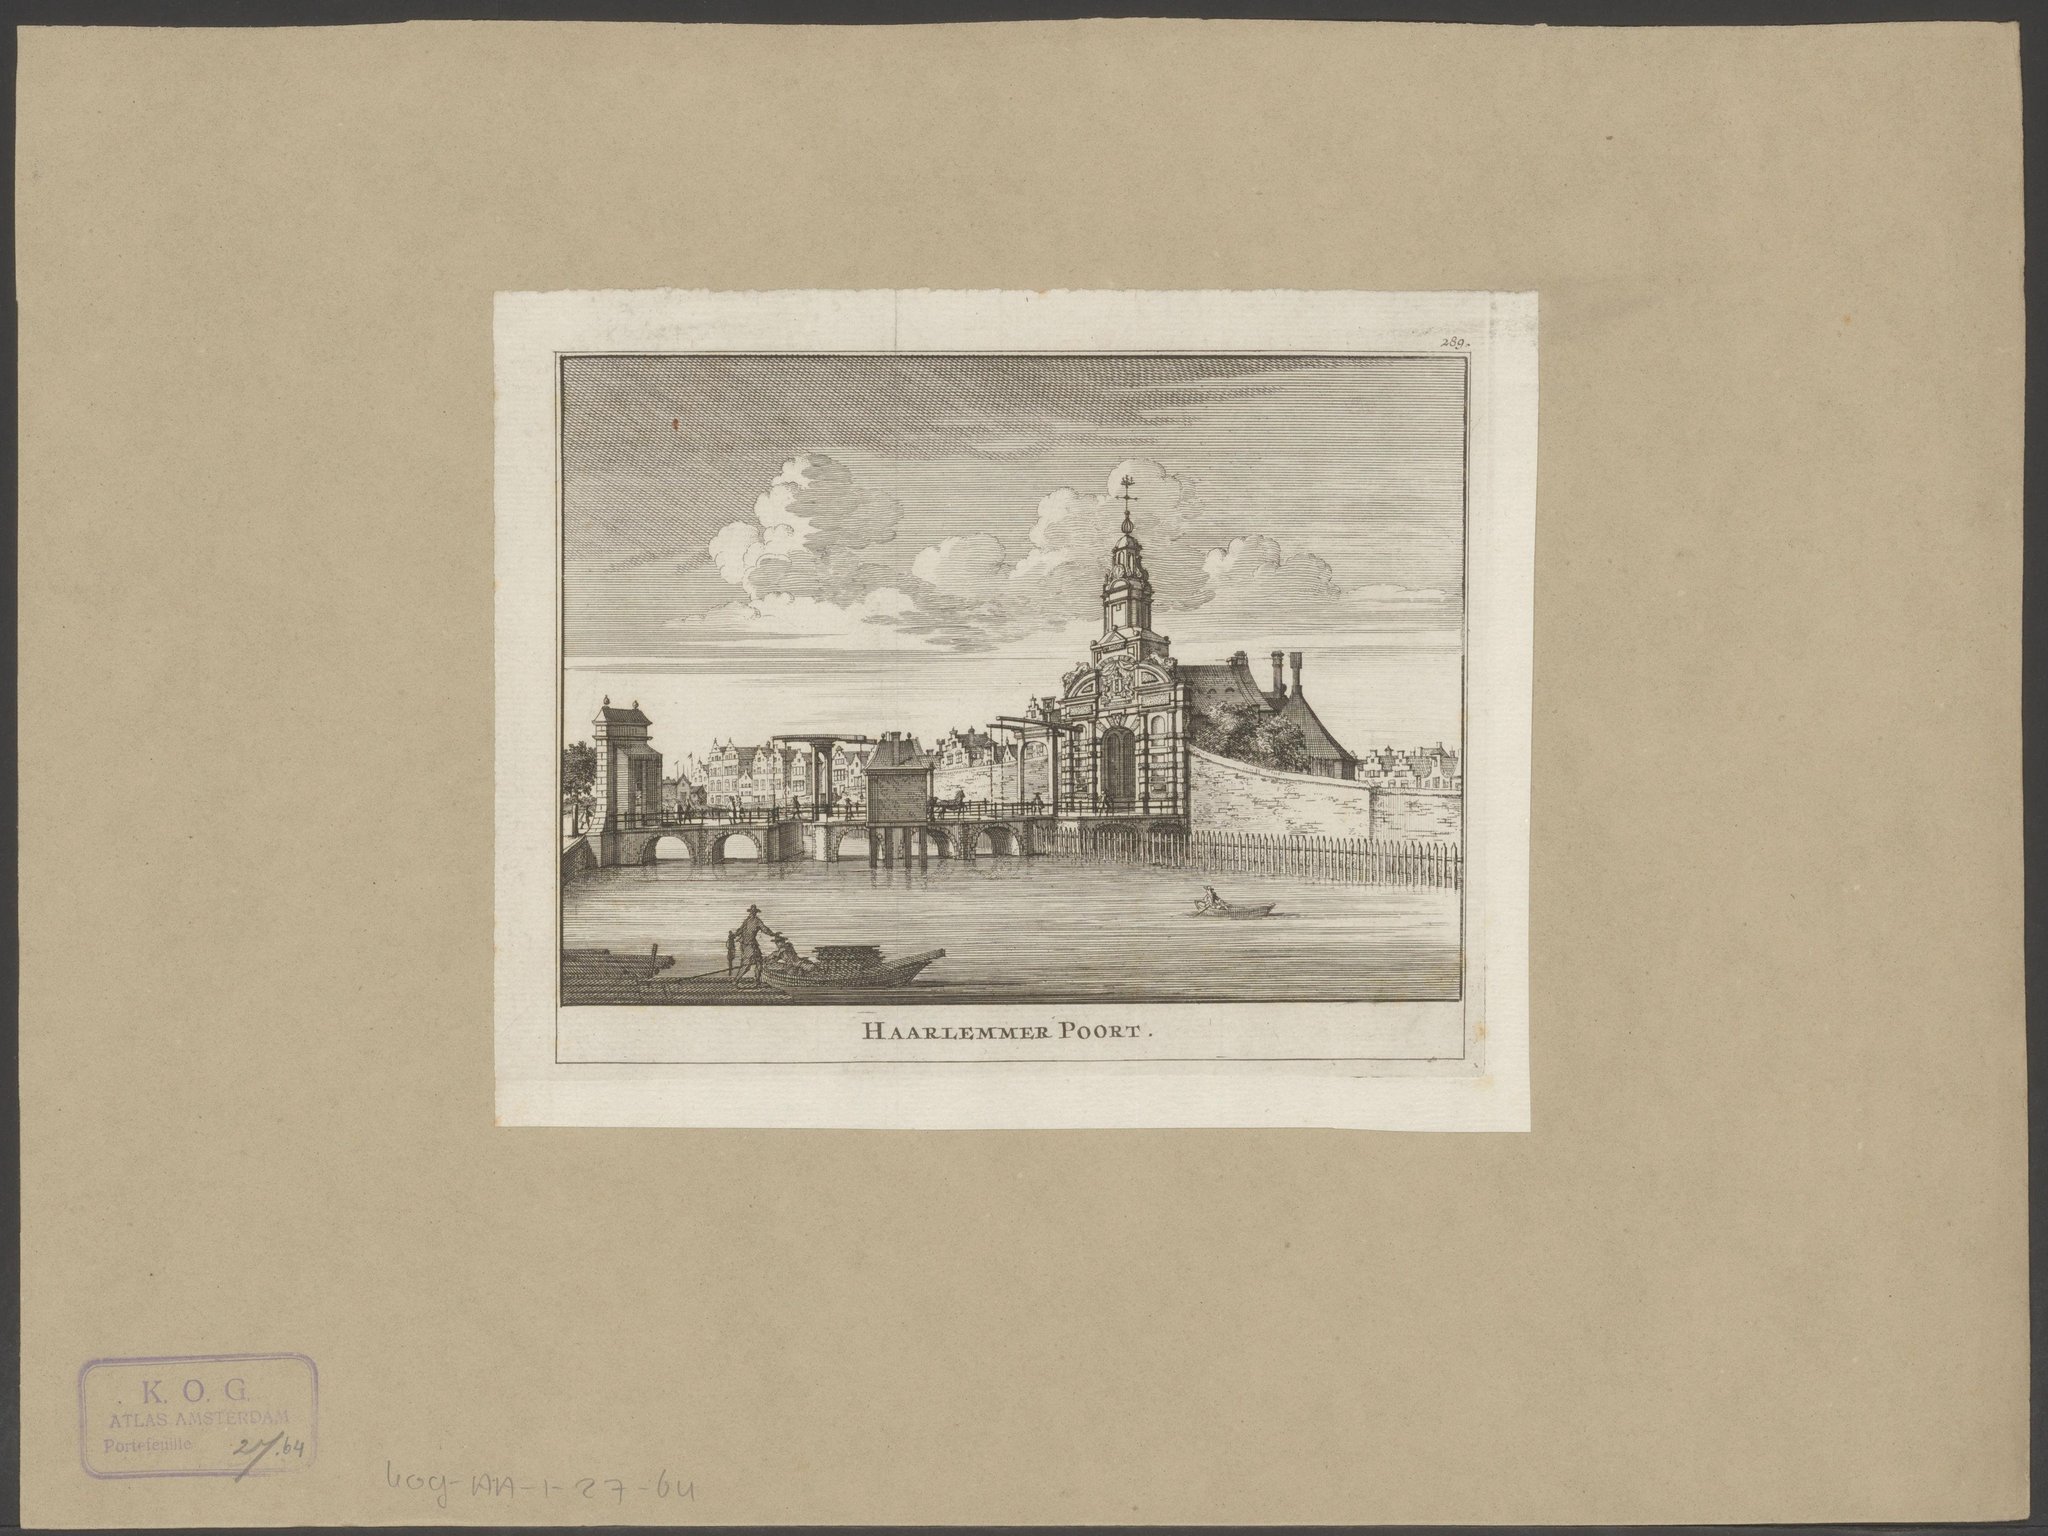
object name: print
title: Gezicht op de Vierde Haarlemmerpoort in Amsterdam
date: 1726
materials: paper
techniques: engraving, etching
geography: amsterdam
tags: rowing-boat, canoe, etc., bridge in city across river, canal, etc., city-gate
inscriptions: collector's mark: Lugt 1641b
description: Prent uit: Hoorn, Nicolaas ten. Wegwyzer door Amsterdam, Zynde eene beknopte verhandeling van desselfs eerste opkomst, vergrootingen, en teegenwoordigen staat (…). 2de druk. Amsterdam: Nicolaas ten Hoorn, 1726, p. 288-289. En in de latere edities (Amsterdam: erven J. Ratelband & Co, 1737, en Amsterdam: Pieter Meyer, 1751). In de eerste editie heeft deze prent een andere plek in het boek, en een ander nummer.